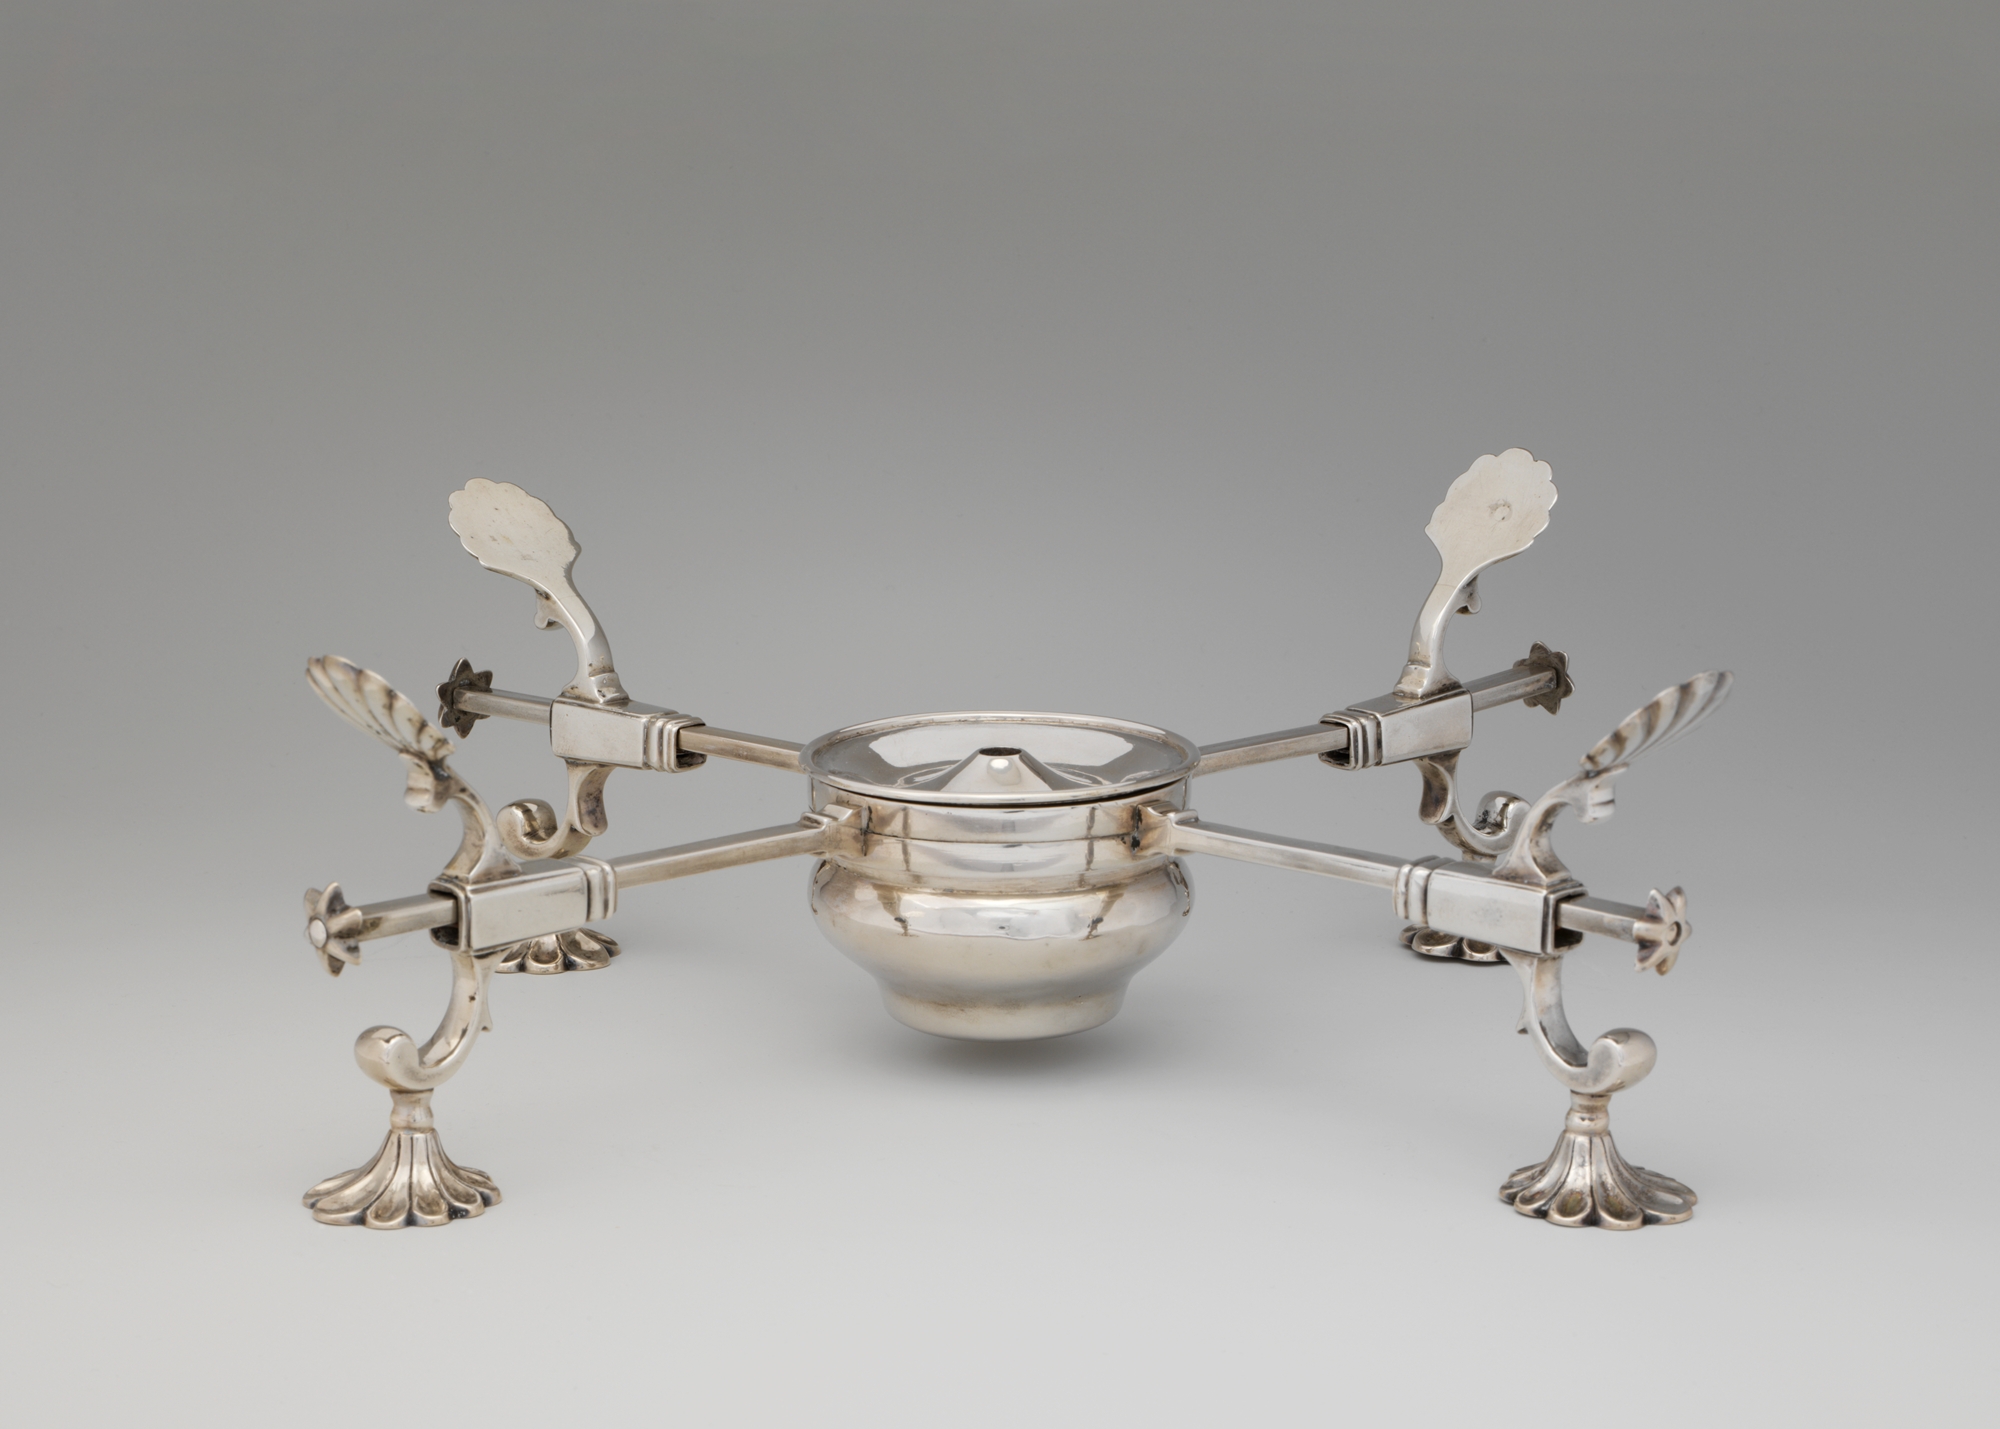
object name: dish cross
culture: american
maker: gerardus boyce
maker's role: maker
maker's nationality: american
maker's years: 1795-1880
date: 1820-1840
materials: silver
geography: united states